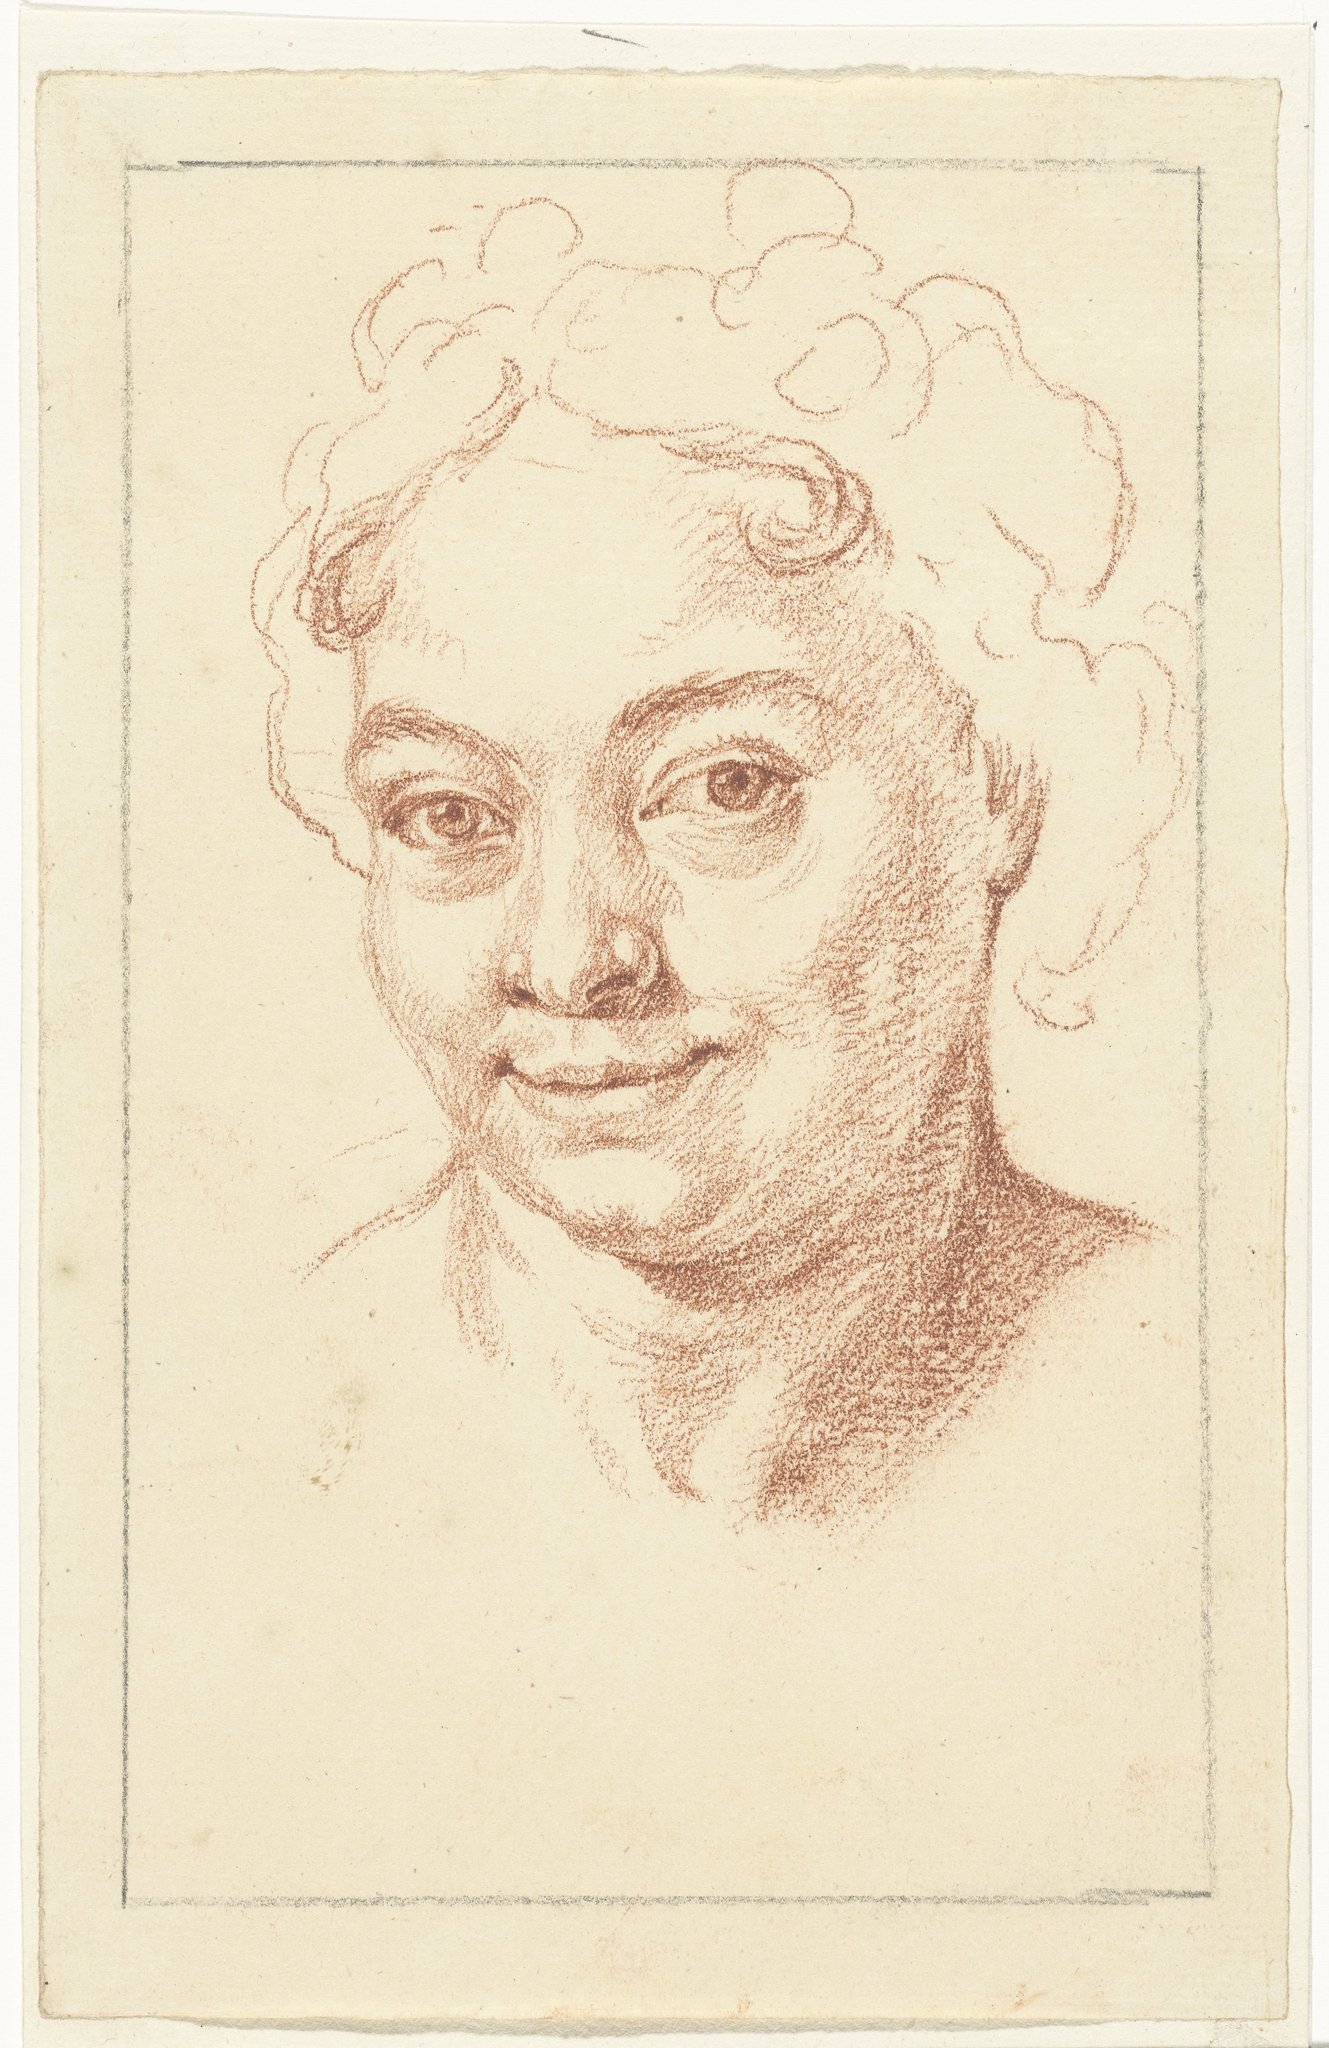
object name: drawing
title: Hoofd van een glimlachende vrouw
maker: bernard picart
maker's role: draughtsman, print maker, publisher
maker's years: 1673-1733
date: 1683-1733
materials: chalk, paper